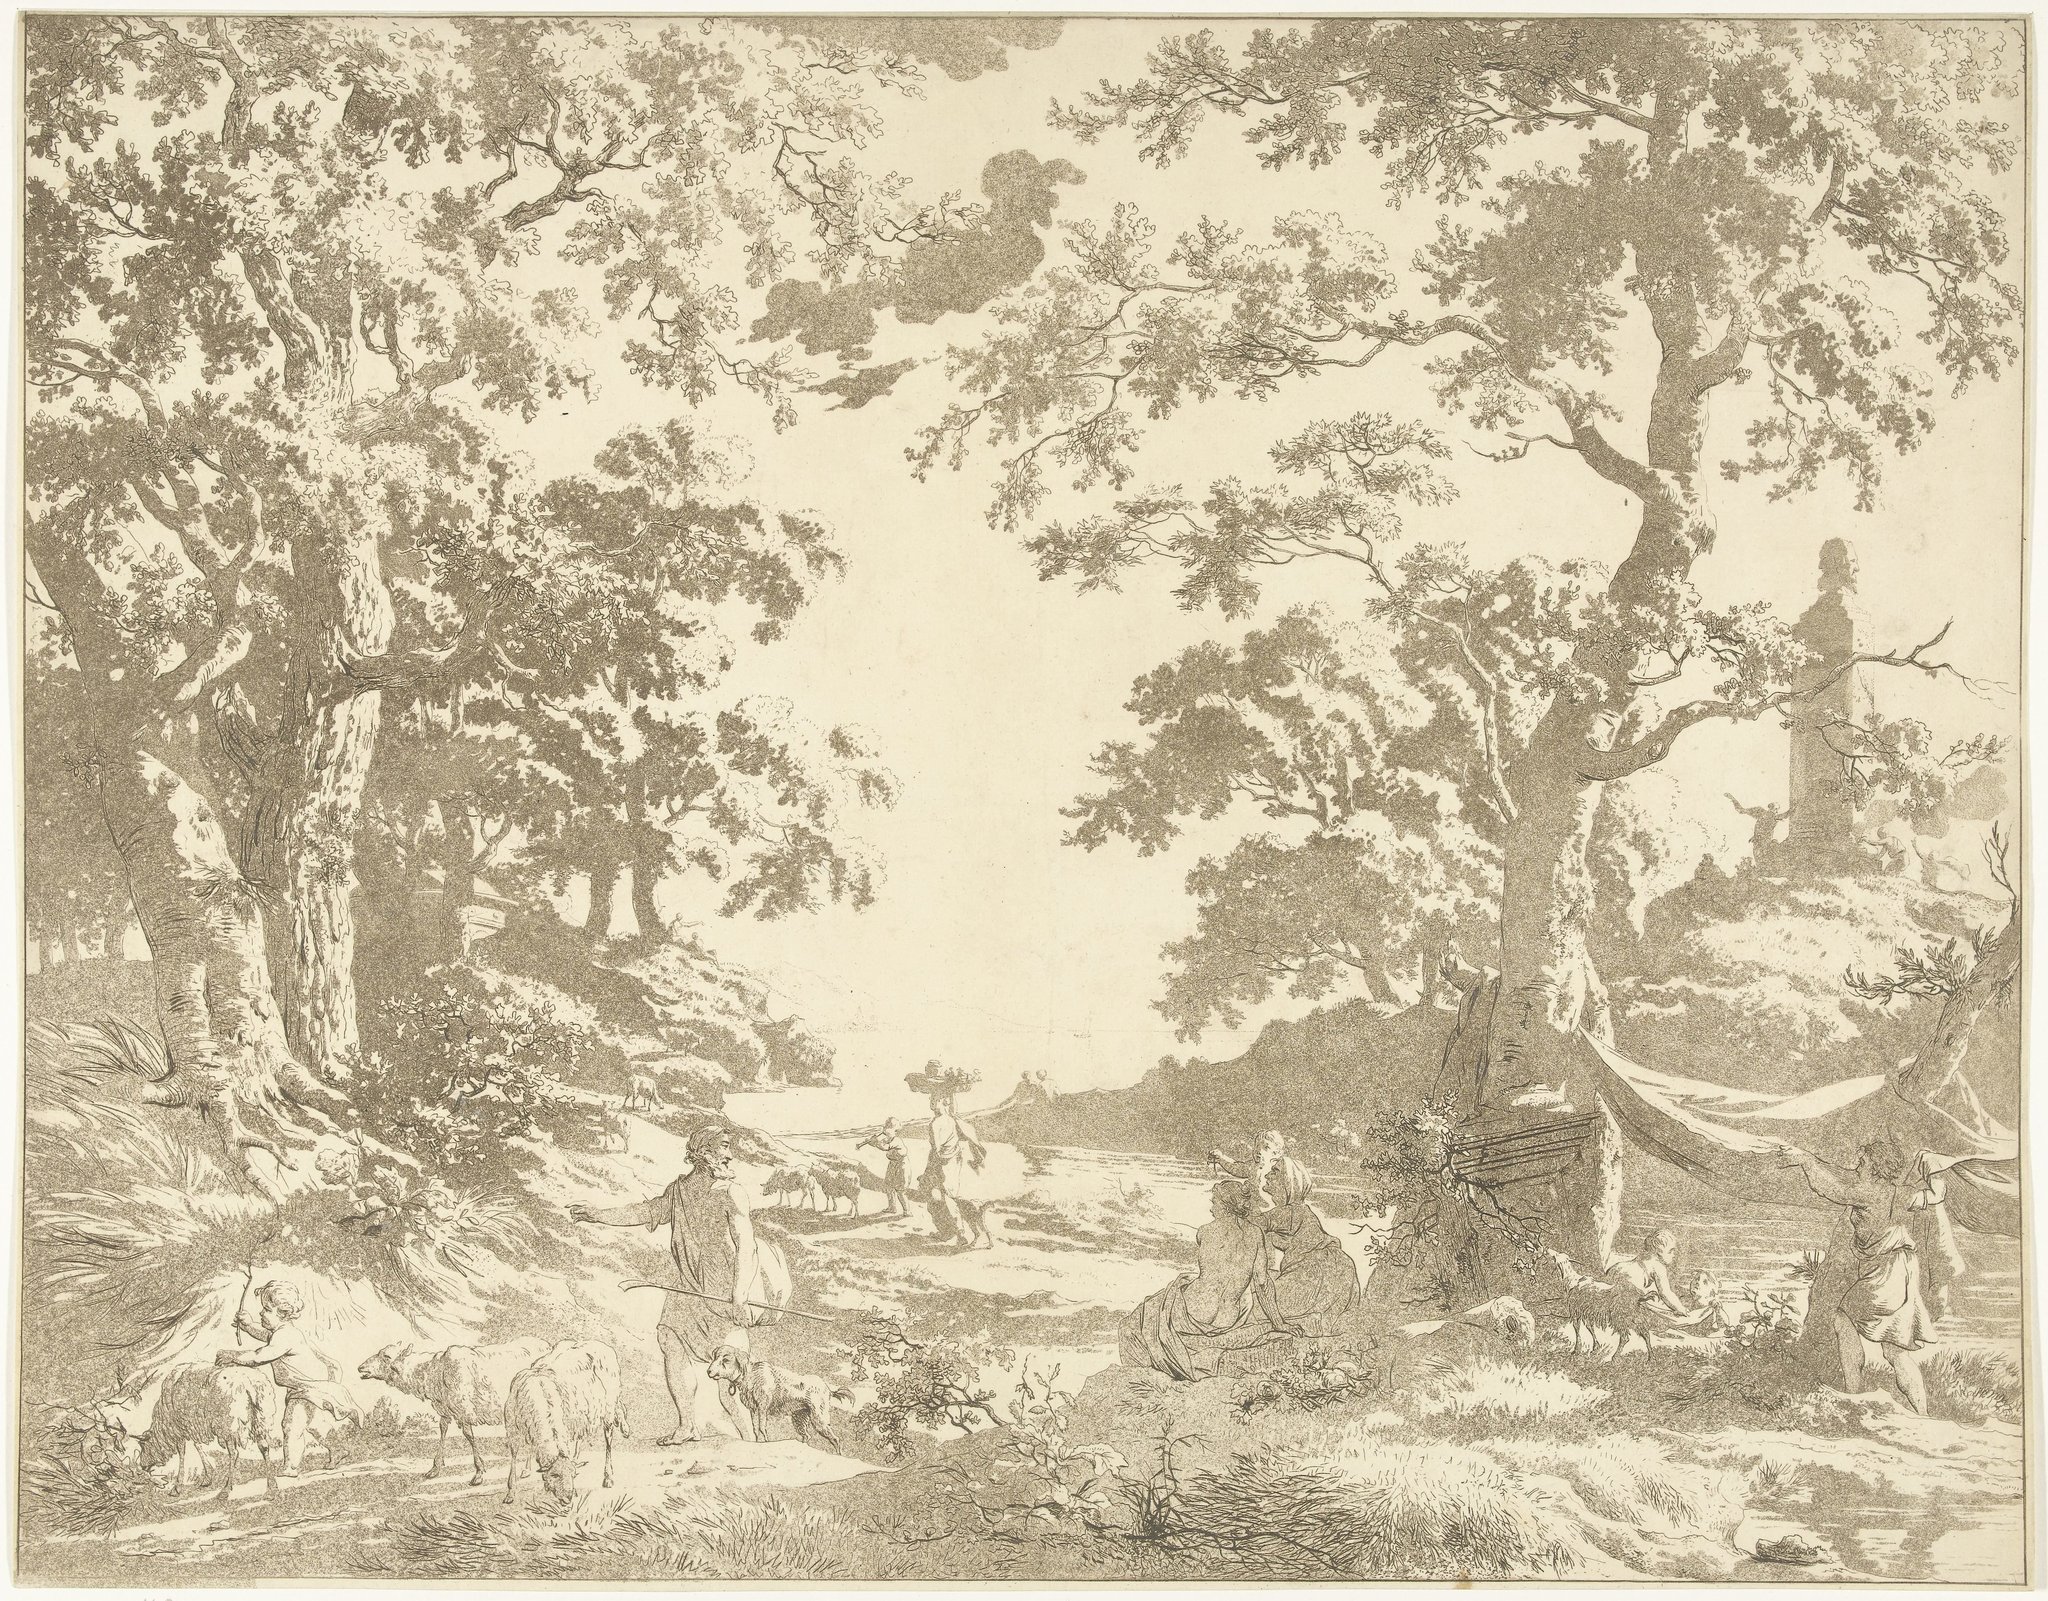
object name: print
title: Arcadisch landschap met Janusbeeld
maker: hermanus fock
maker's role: conservator, draughtsman, painter, print maker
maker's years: 1766-1822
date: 1781-1822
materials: paper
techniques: aquatint, etching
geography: amsterdam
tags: janus' head, two-faced head, pastorals, arcadian scenes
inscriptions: collector's mark: Lugt 2228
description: Landschap met hoge bomen en personen en schapen langs de oever van een rivier. Op de voorgrond een schaapsherder met een hond en een kind tussen drie schapen. Op de achtergrond, rechts, een Janusbeeld op een heuvel.